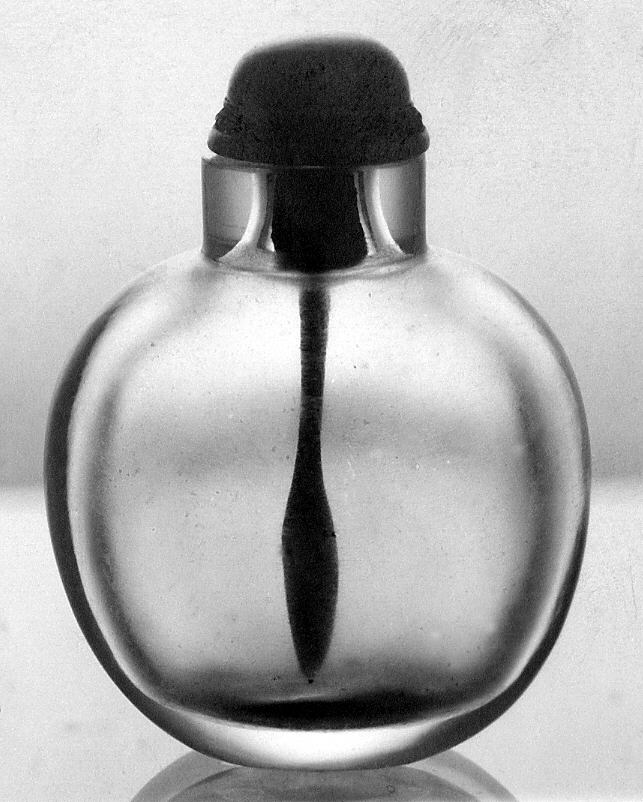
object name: snuff bottle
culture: chinese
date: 1701-1800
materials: jade, quartz